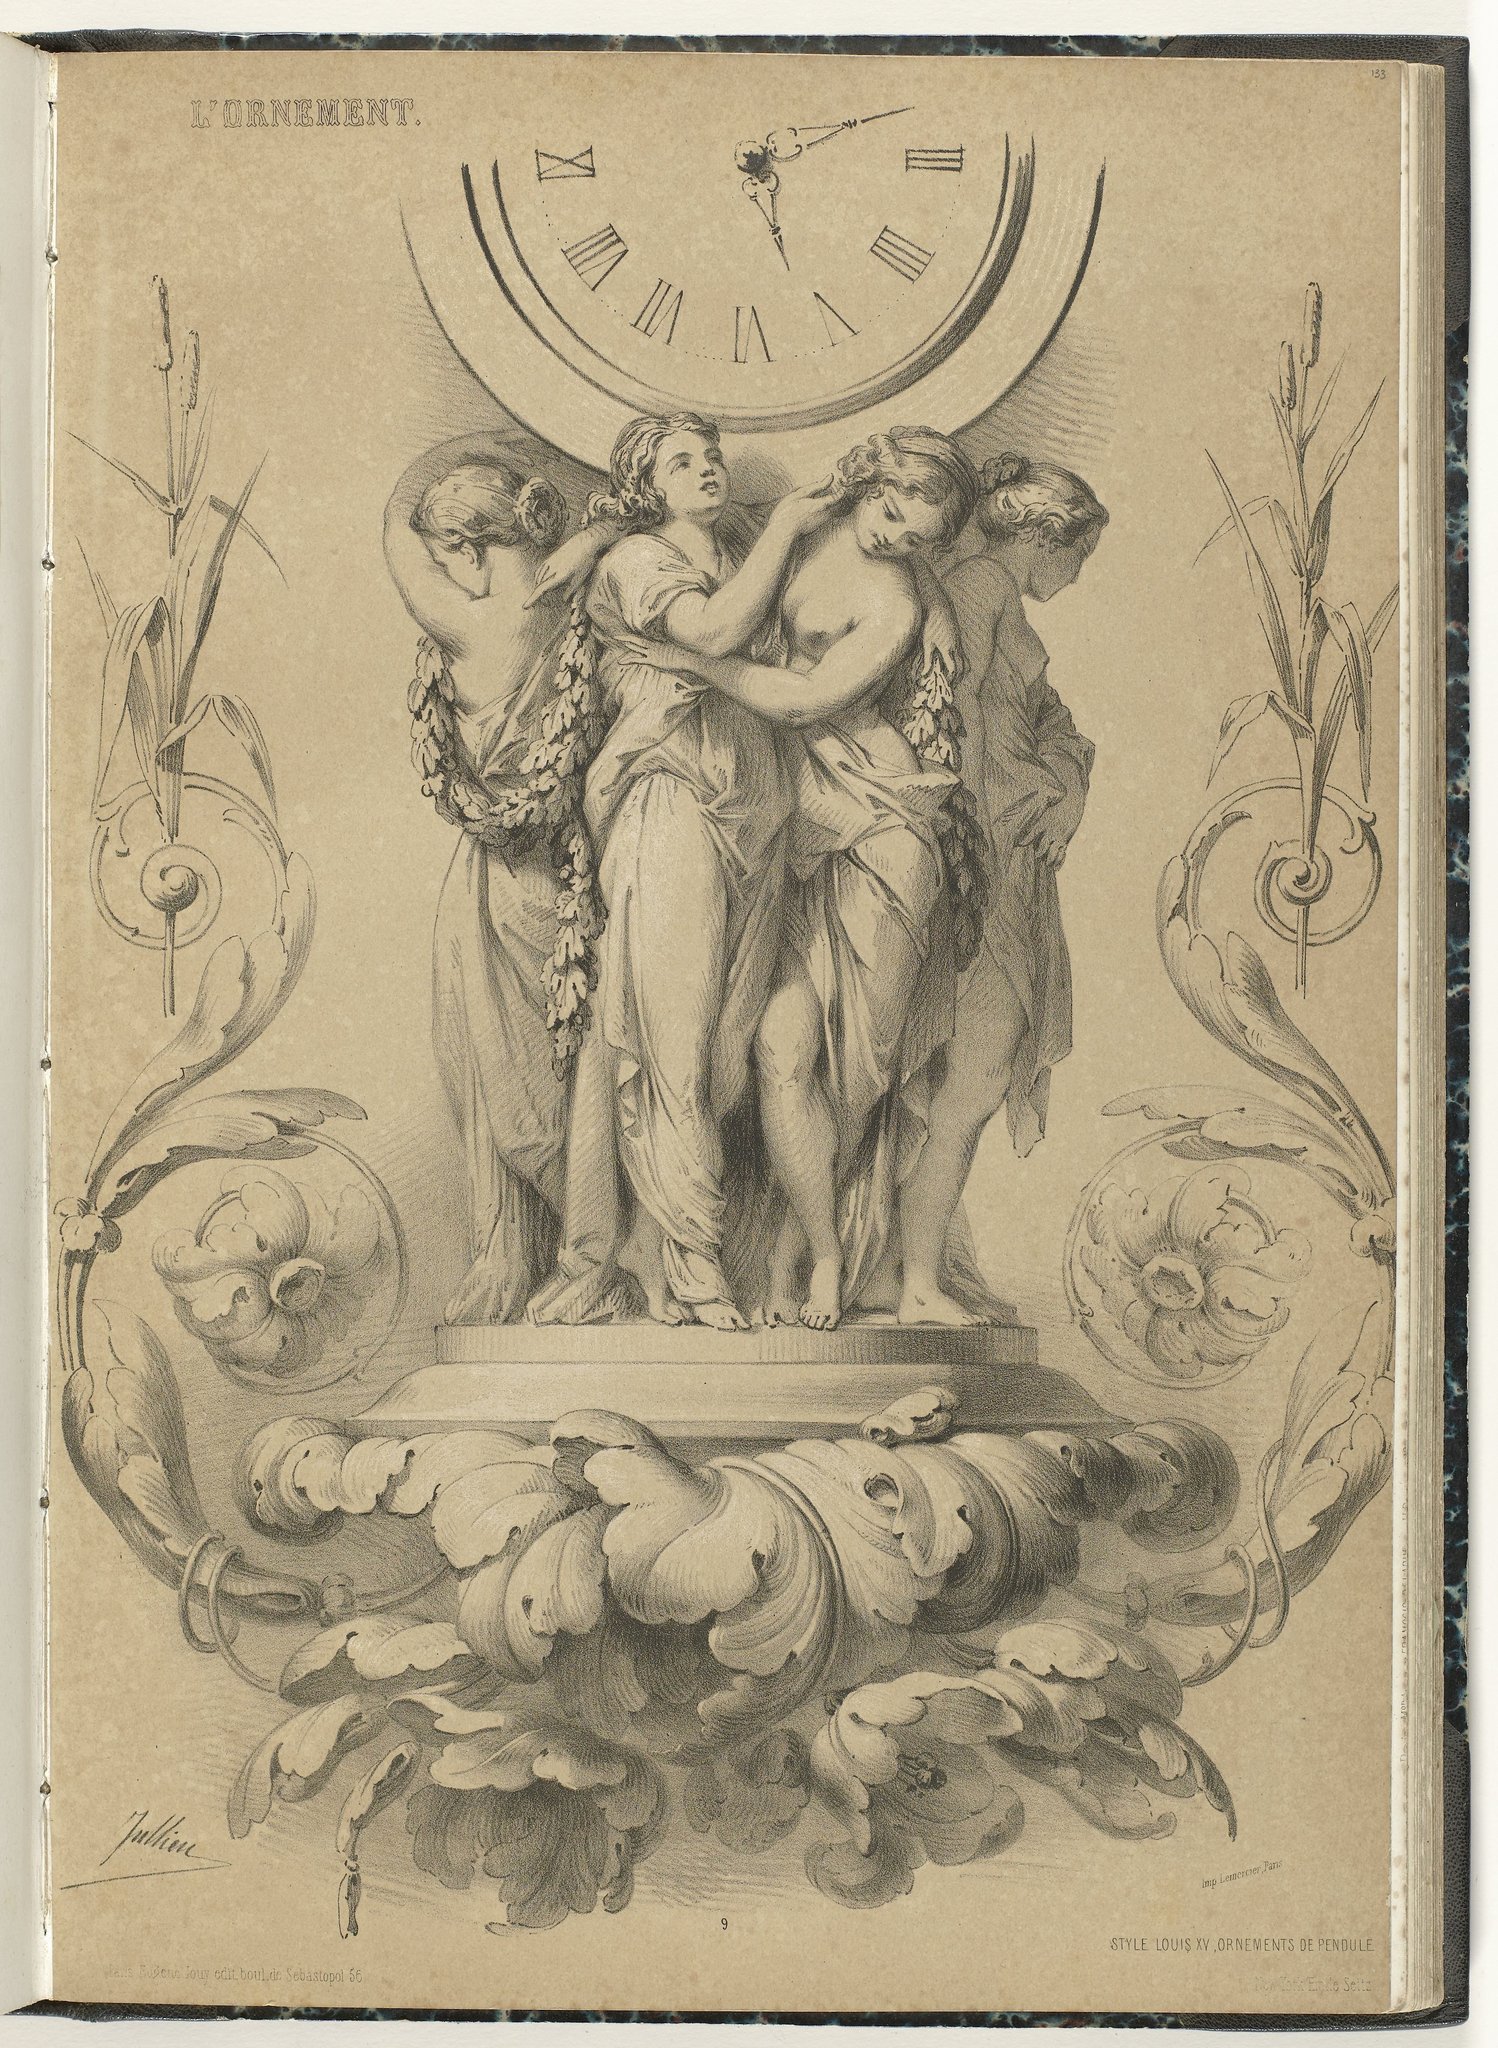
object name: print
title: Klok ondersteund door vier vrouwen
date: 1866-1900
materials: paper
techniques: lithograph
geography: paris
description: De vrouwen staan op een voetstuk waar bladranken onderuit komen.